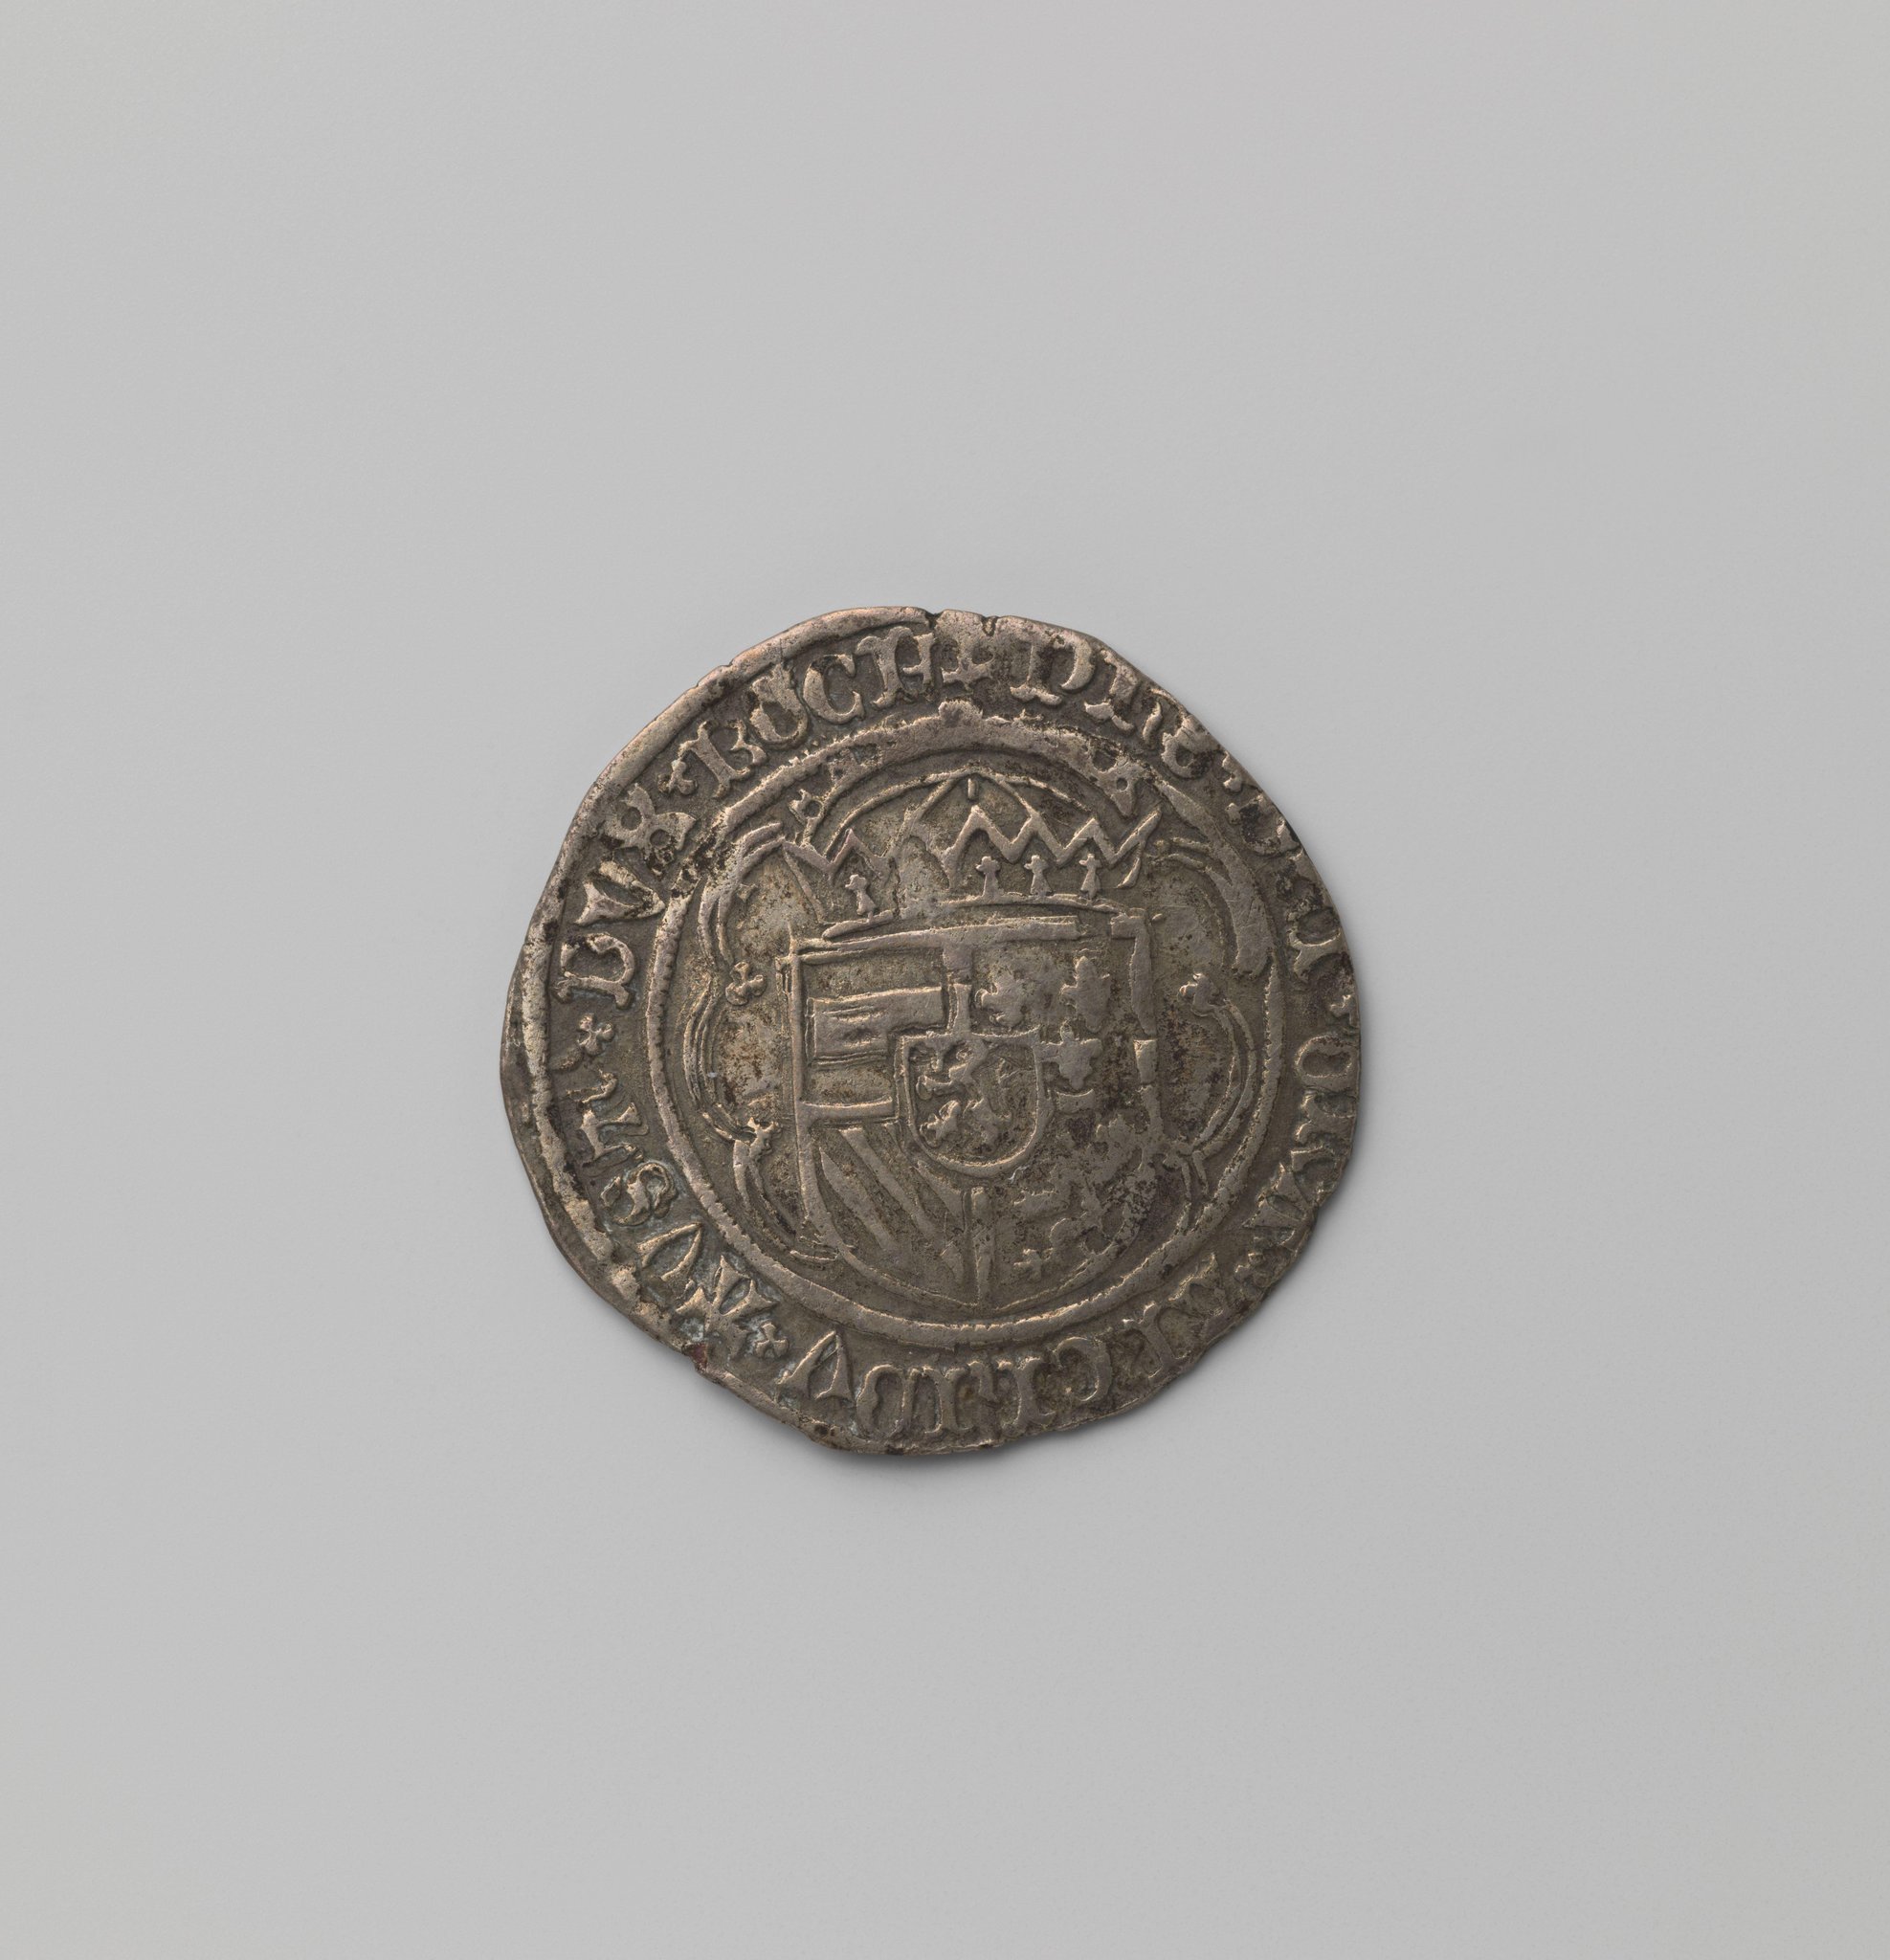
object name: coin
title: Vlaanderen, Philips de Schone, dubbele stuiver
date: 1482-1506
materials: silver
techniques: striking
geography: bruges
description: Zilveren munt. Voorzijde: in een veelpas gekroond samengesteld wapenschild van Bourgondië. Keerzijde: kort gebloemd kruis, in het hart lelie.